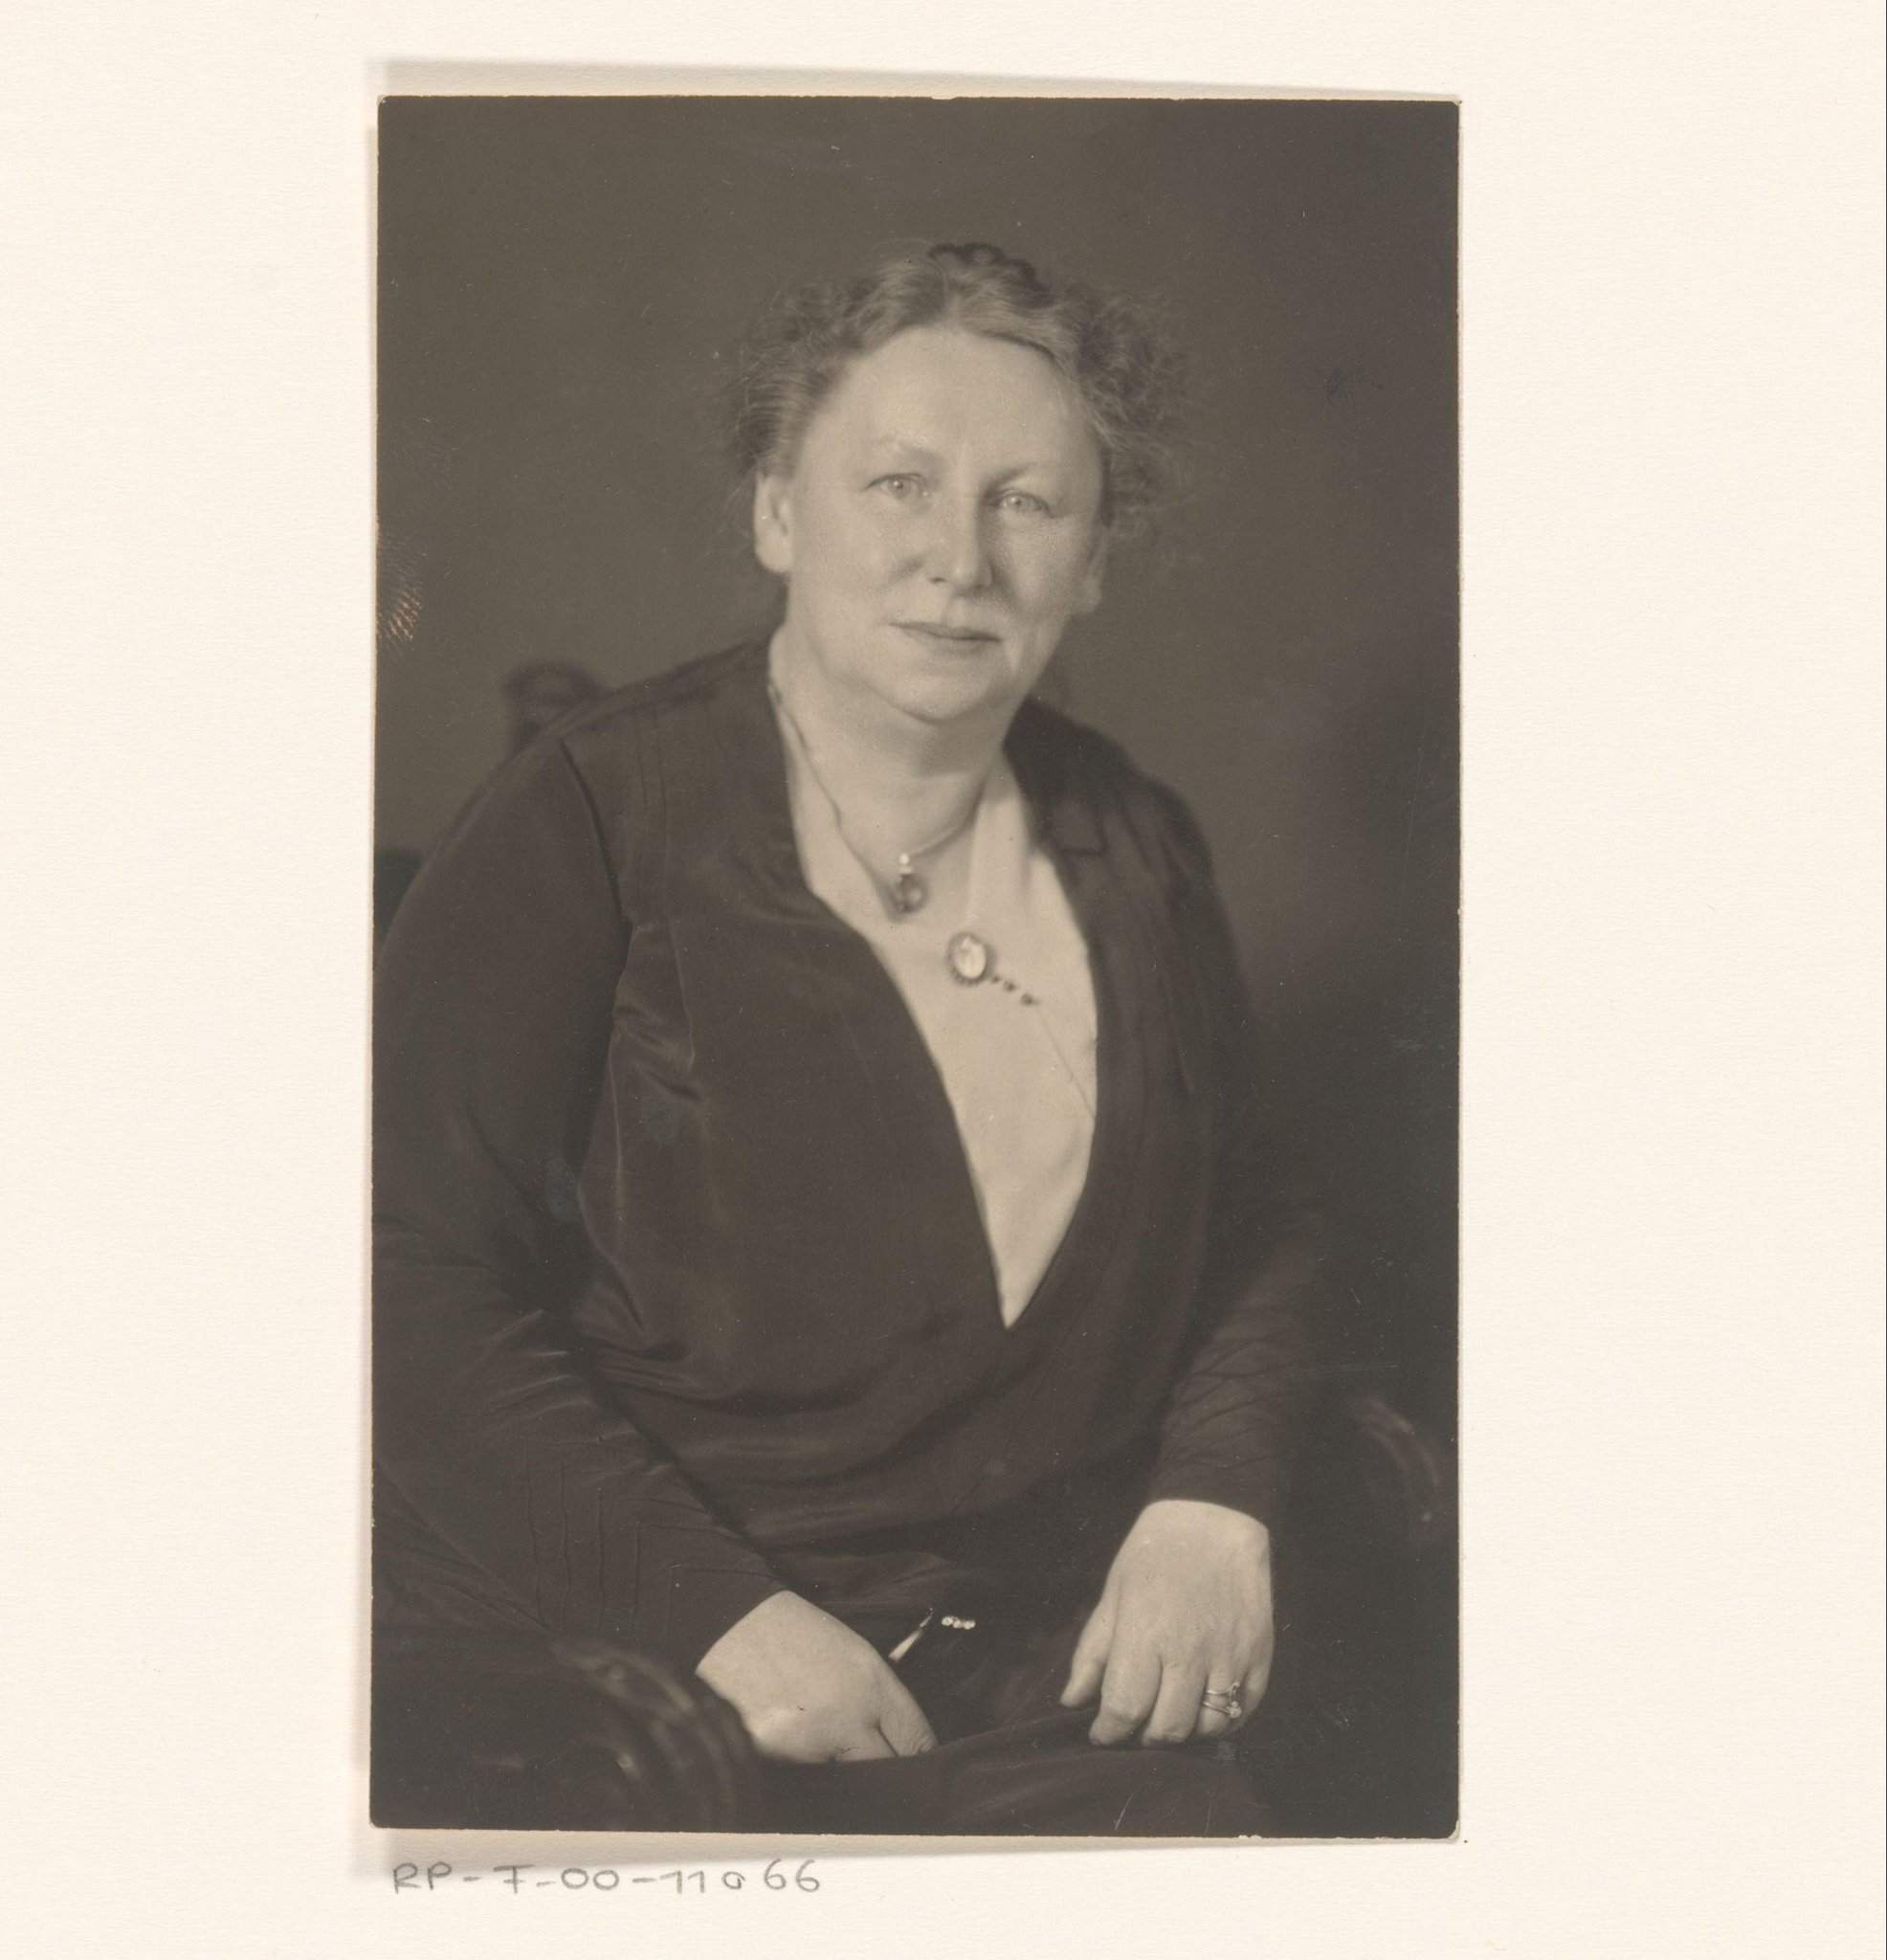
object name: photograph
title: Portret van een onbekende vrouw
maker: Anonymous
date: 1900-1950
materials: photographic support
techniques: gelatin silver print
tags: sitting figure - aa - female human figure, historical persons not known by name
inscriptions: collector's mark: Lugt 2228a, :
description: Vermoedelijk een portret van een schrijver.